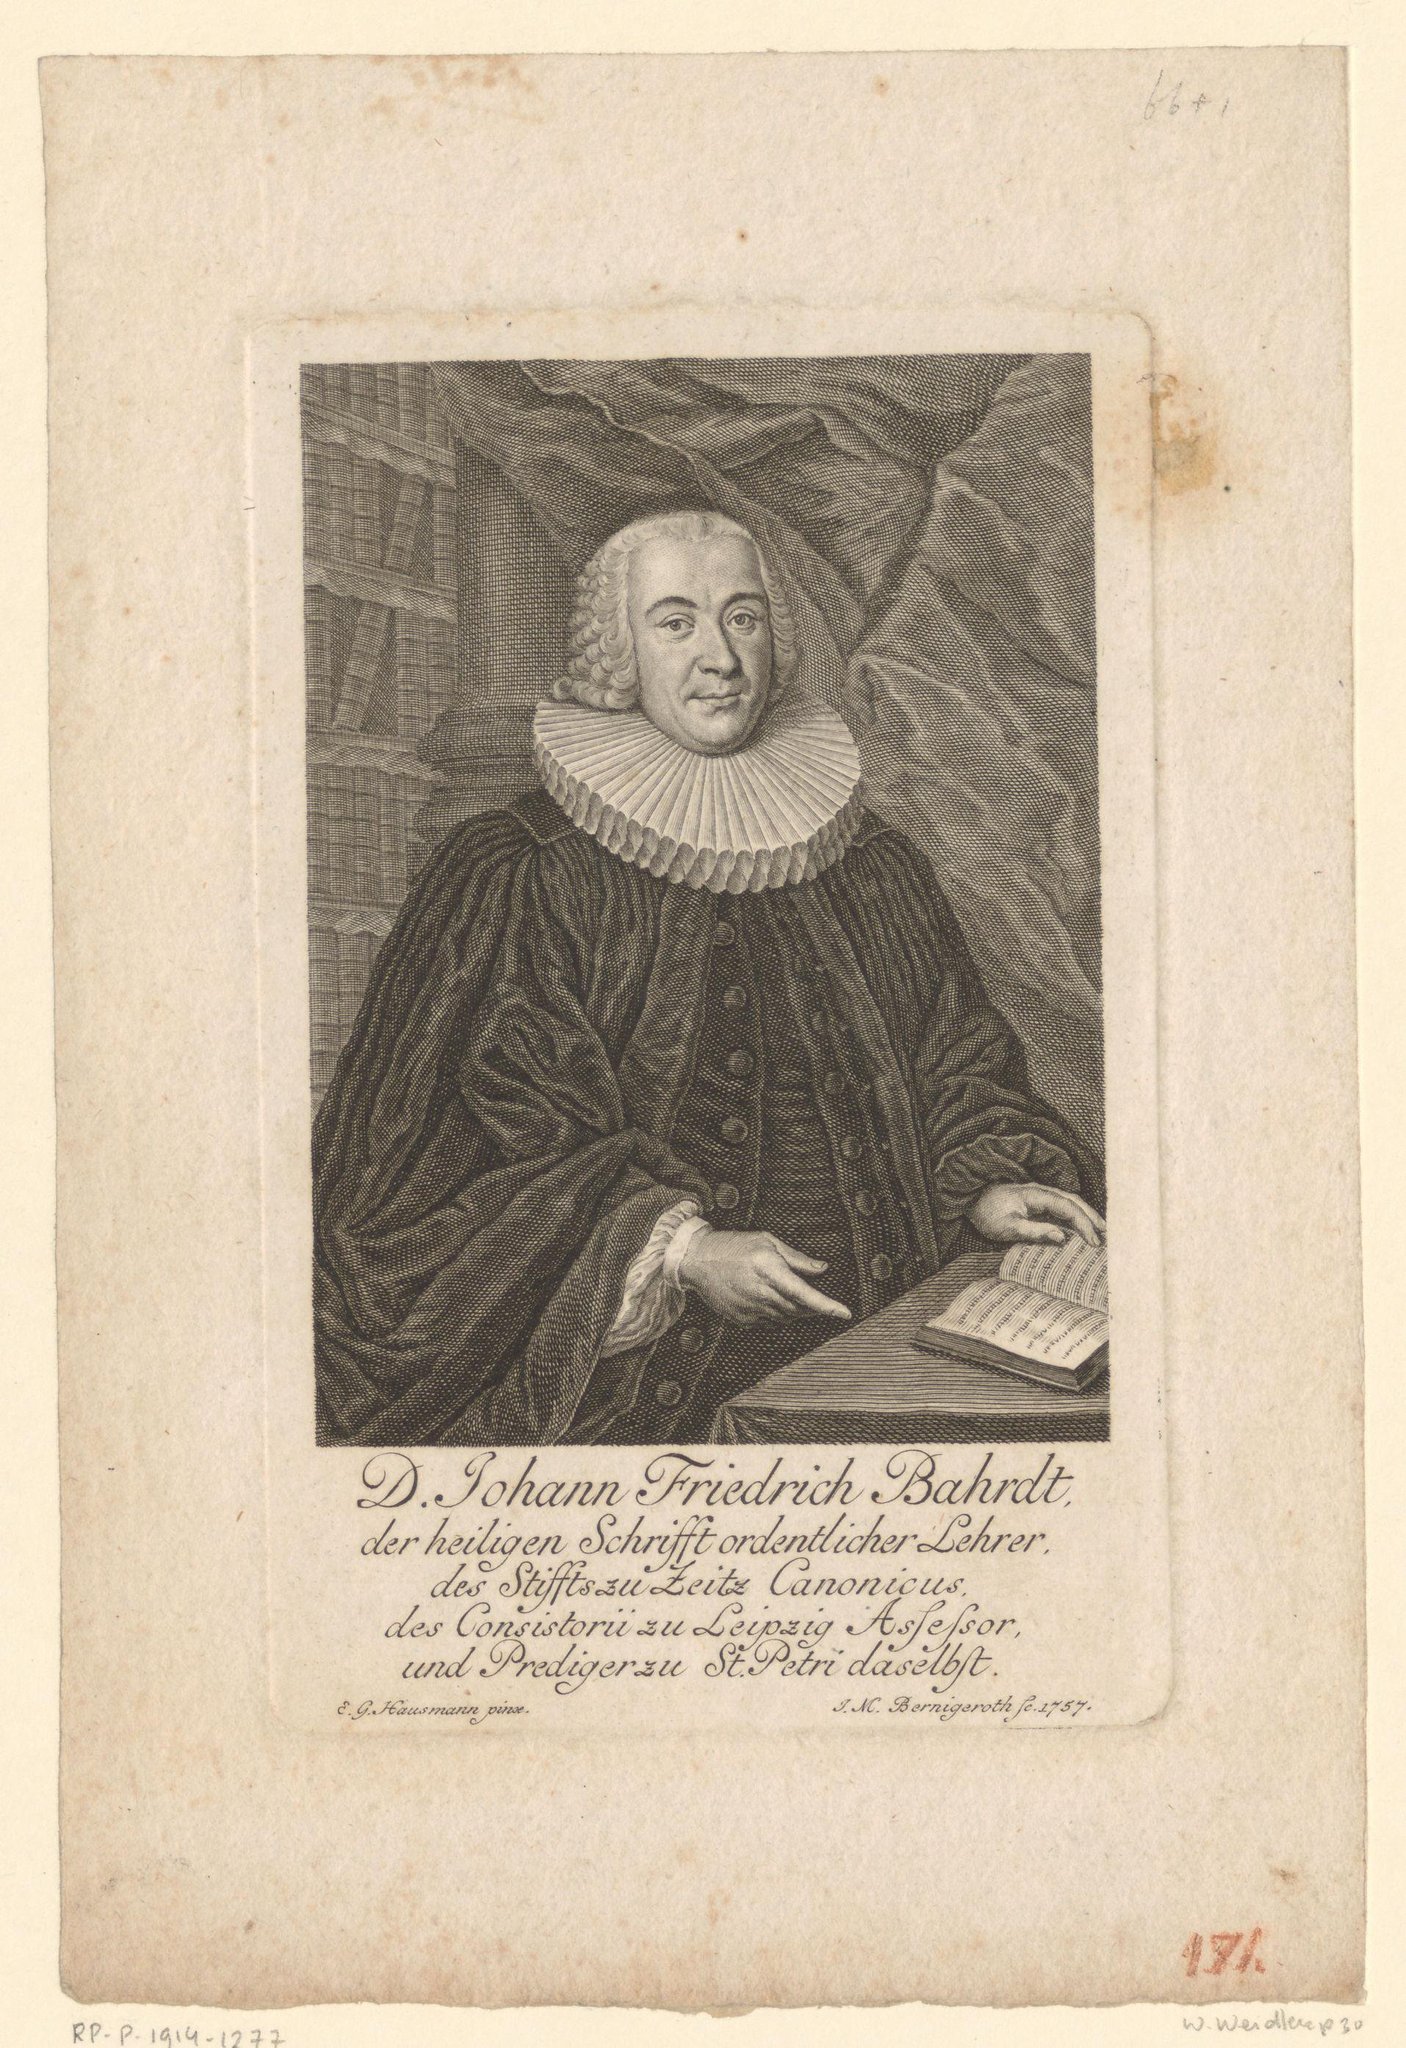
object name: print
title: Portret van Johann Friedrich Bahrdt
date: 1757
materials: paper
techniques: engraving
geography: leipzig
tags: bookshelves, historical persons, book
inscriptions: collector's mark: Lugt 2228